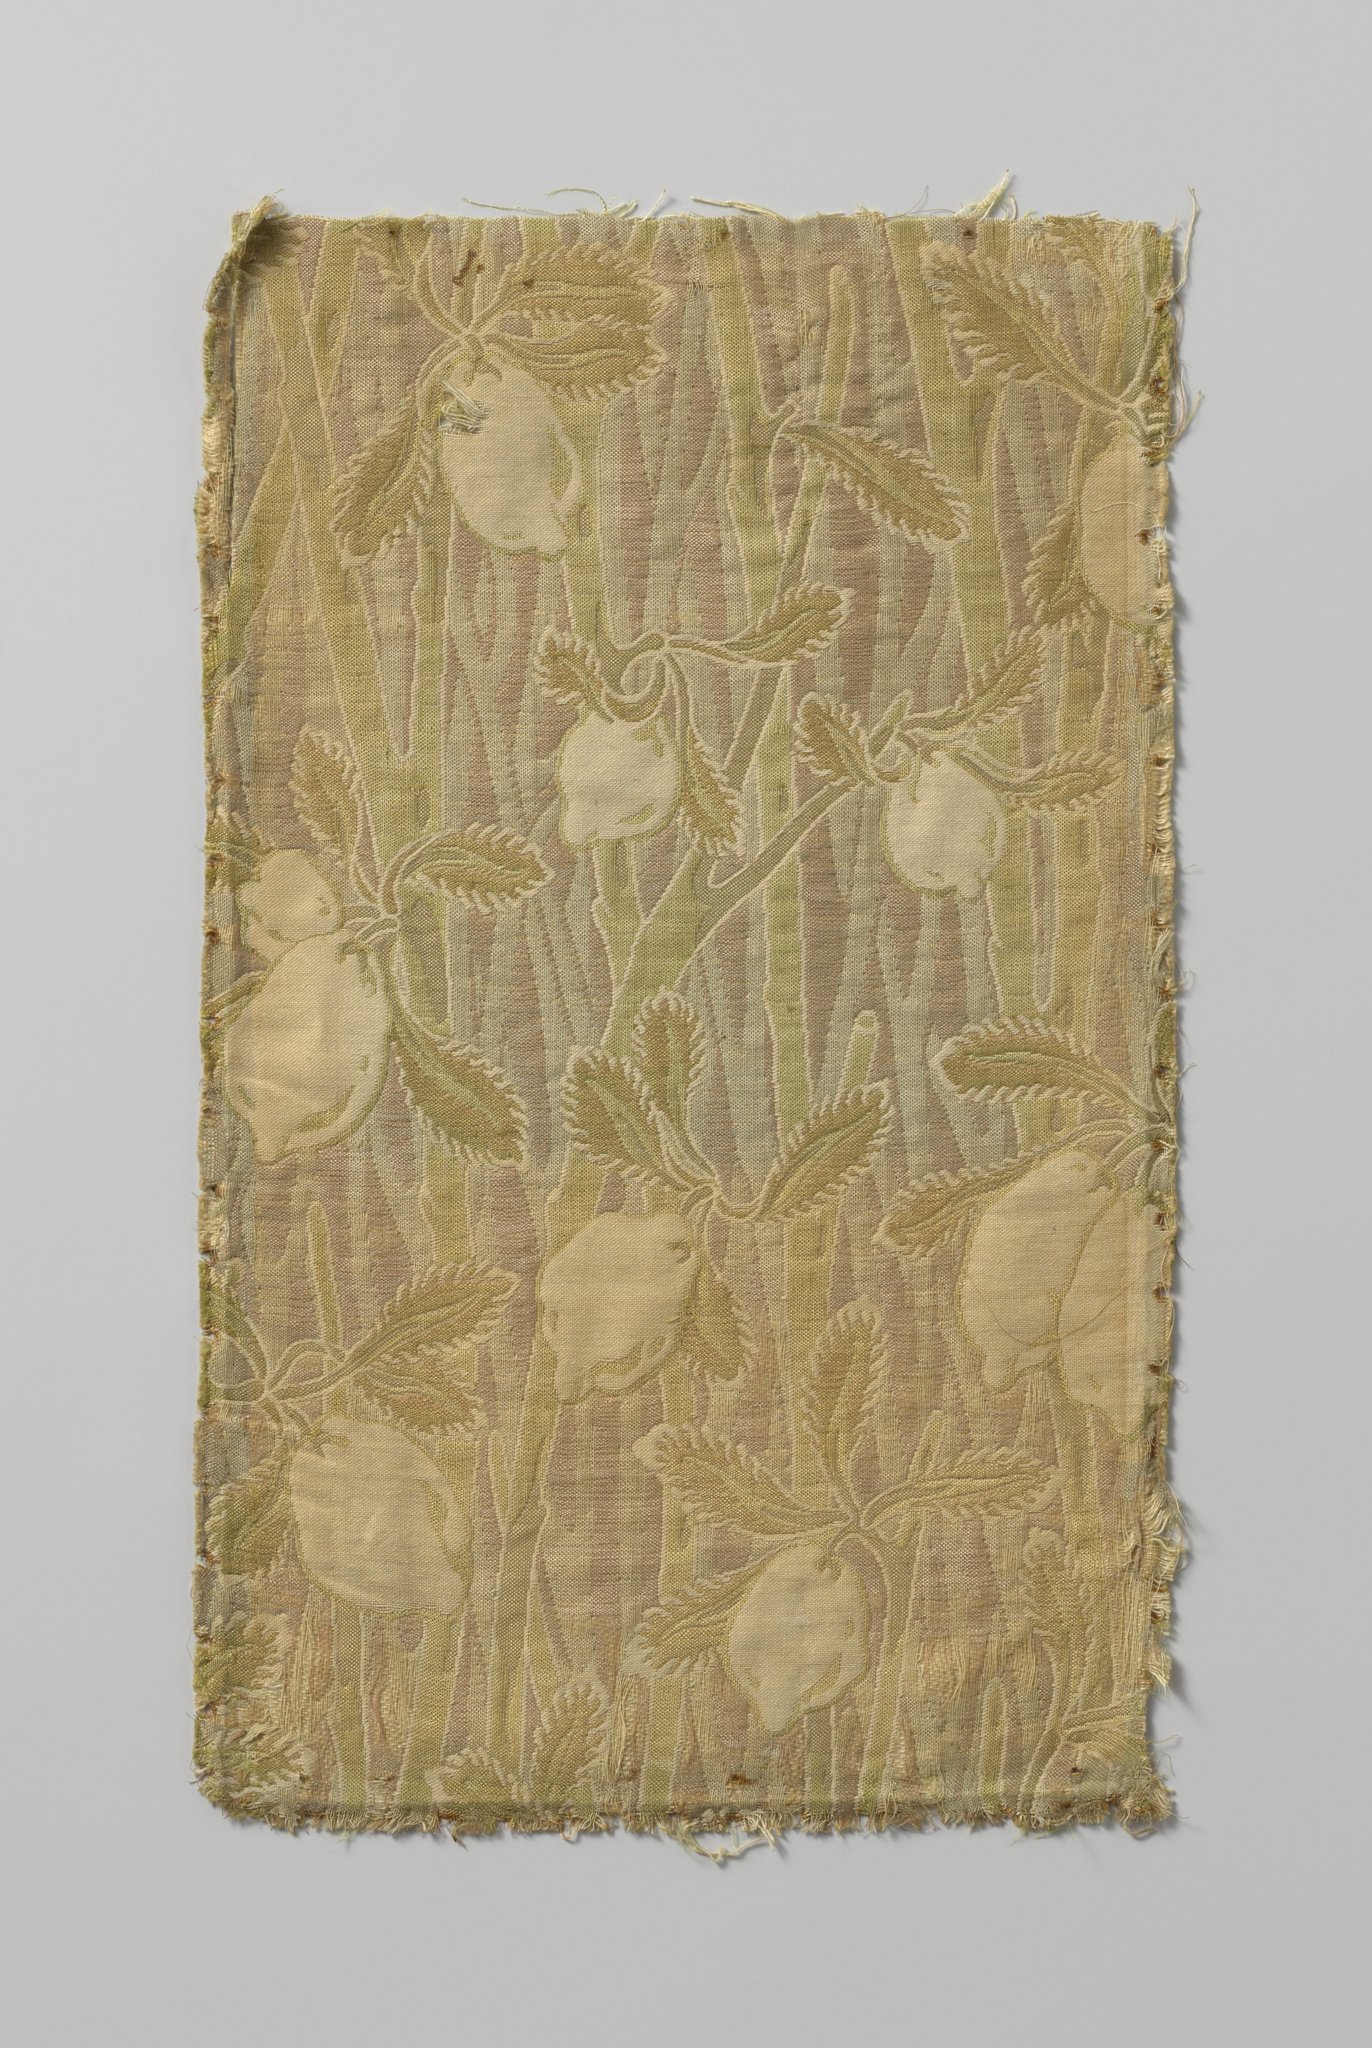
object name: fragment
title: Fragment halfzijden weefsel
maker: Anonymous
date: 1875-1900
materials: cotton, silk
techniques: double weave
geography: europe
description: Fragment halfzijden weefsel. Het fragment heeft een onregelmatig patroon van vertakte twijgen in olijf- en mosgroen, waaraan citroenachtige vruchten in wit, omkranst door een bladertros, op een beige-bruine grond.